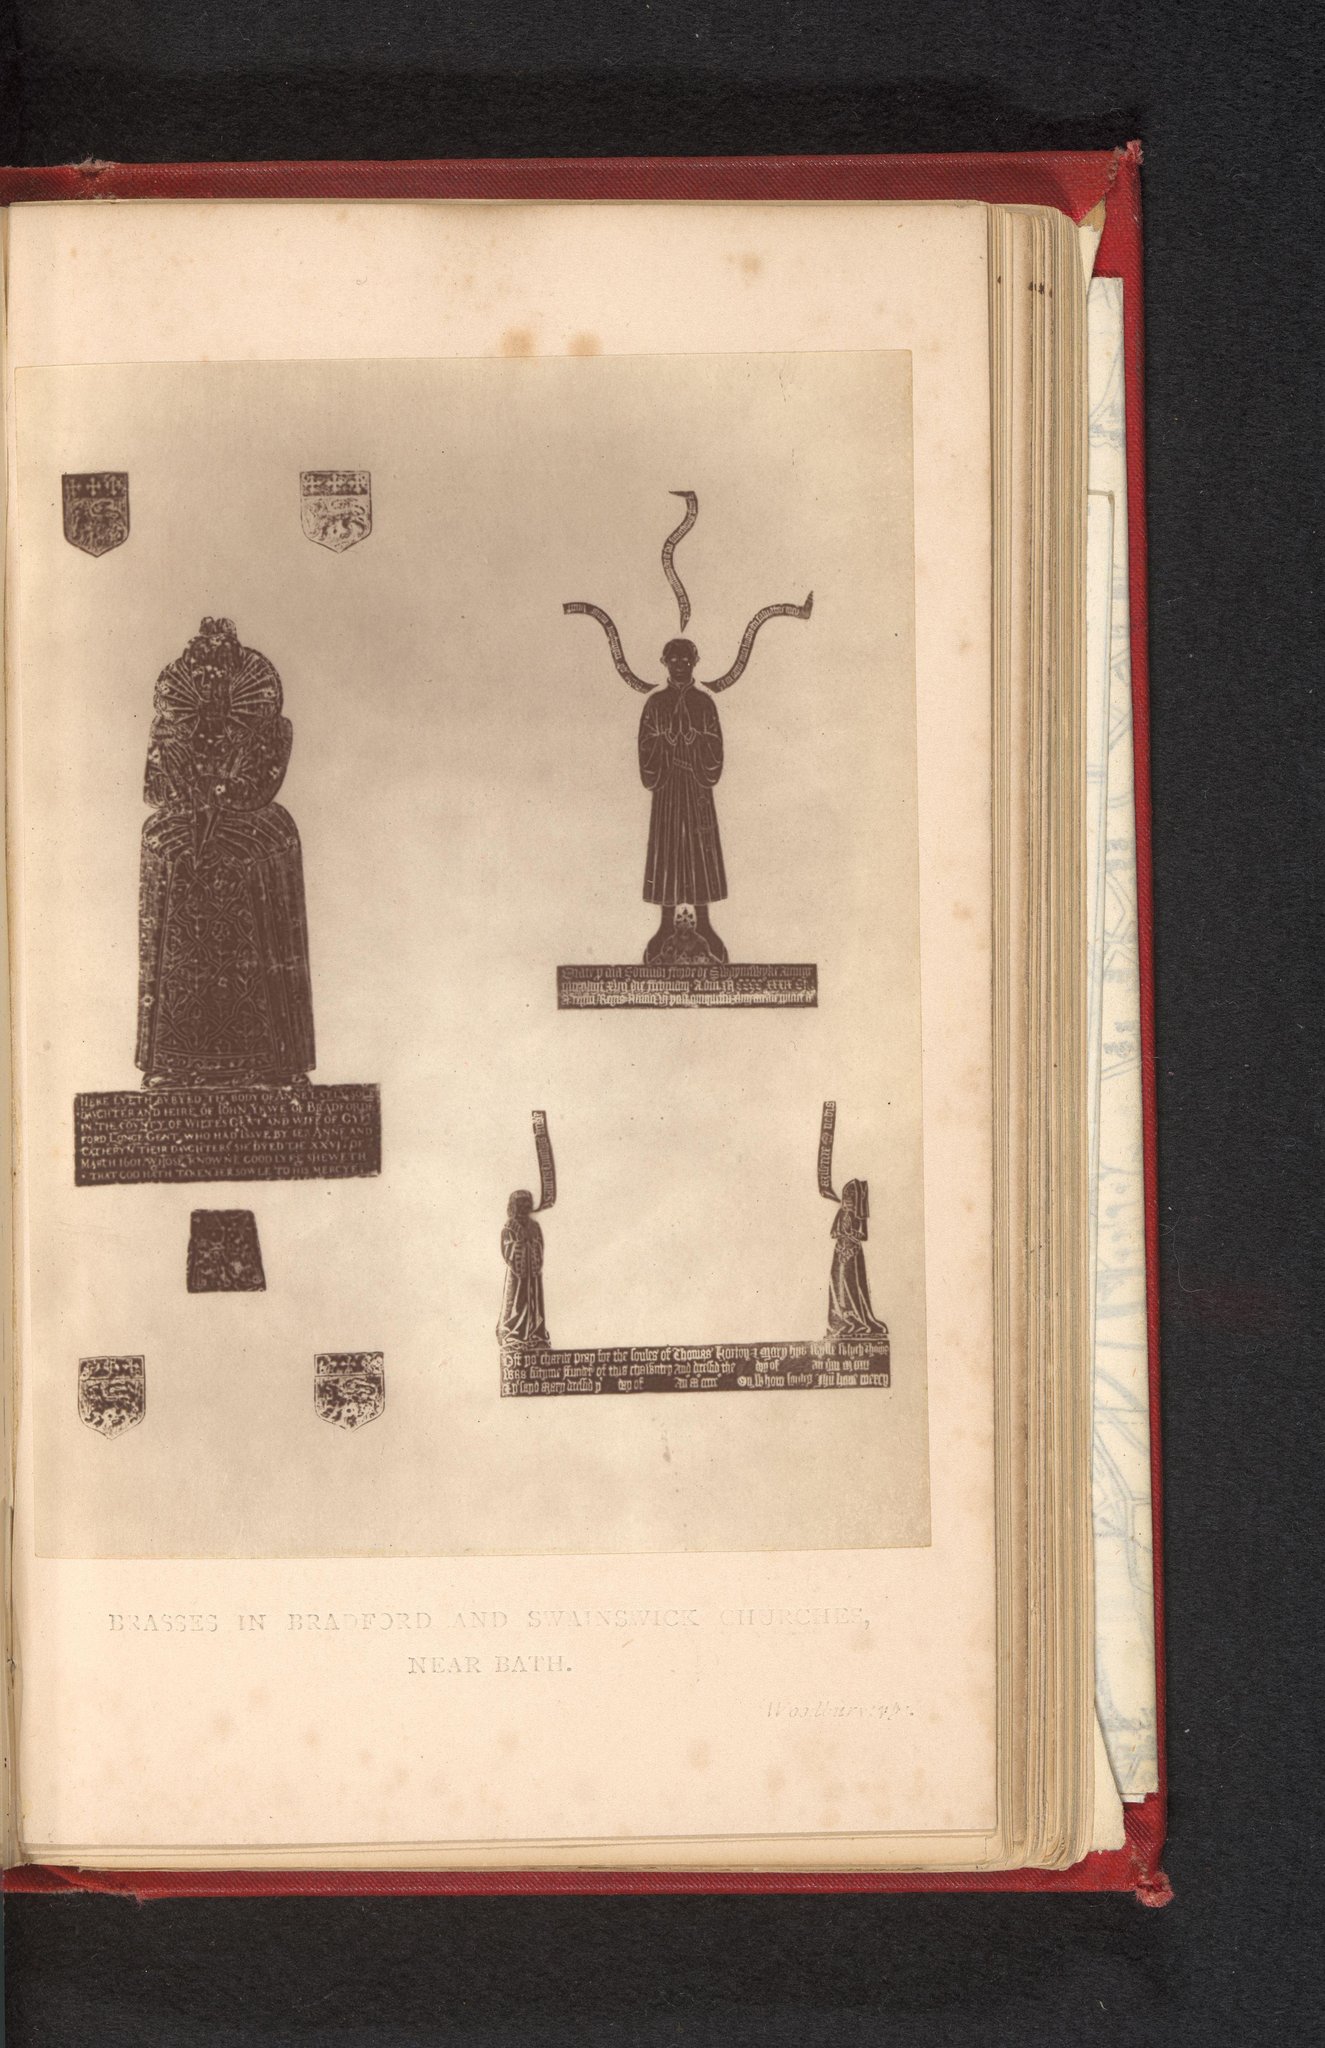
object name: photomechanical print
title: Messing objecten uit de kerken van Bradford en Swainswick, in de buurt van Bath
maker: foote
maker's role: fotograaf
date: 1871-1876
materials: paper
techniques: woodburytype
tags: piece of sculpture, reproduction of a piece of sculpture